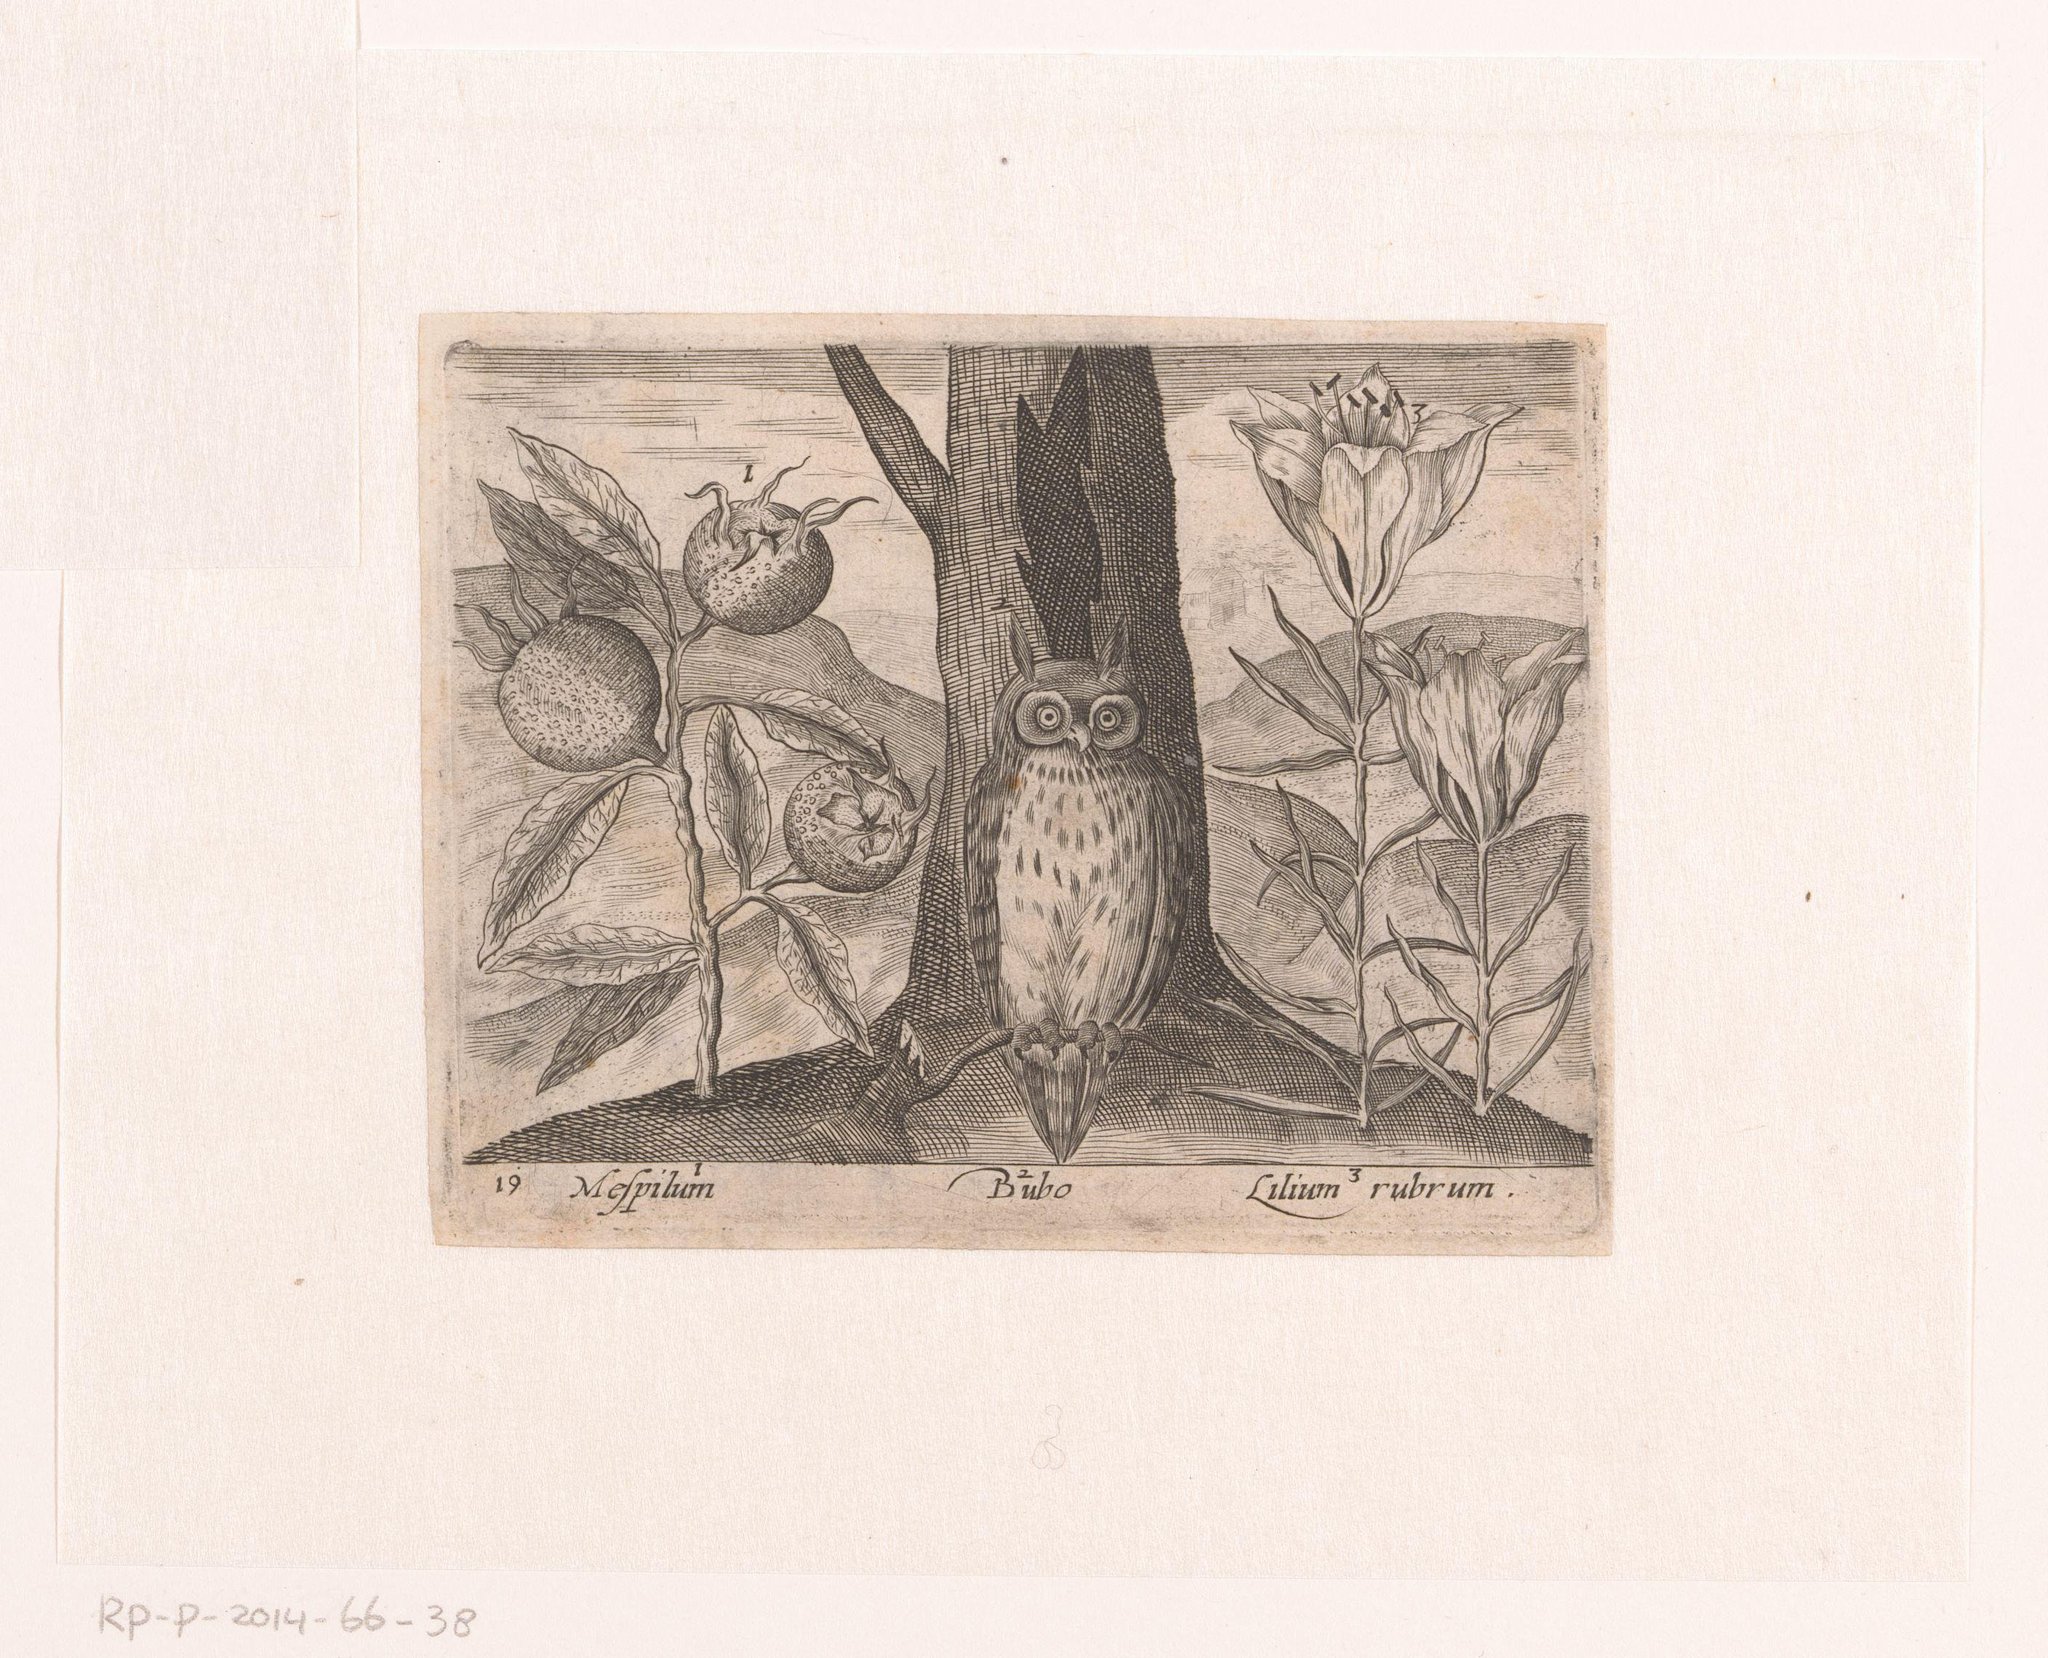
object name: print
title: Series of Prints with Flowers and Animals in a Landscape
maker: johann hogenberg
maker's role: print maker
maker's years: 1550-1618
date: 1600-1605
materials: paper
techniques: engraving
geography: germany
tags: fruits: medlar, owls, flowers: lily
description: In making his representations of flowers and animals Hogenberg borrowed freely from prints by other artists. Some combinations are endearing, others slightly bizarre. What does a polar bear have to do with artichokes? It is precisely the series’ mixture of originality and naiveté that is so appealing to modern eyes.